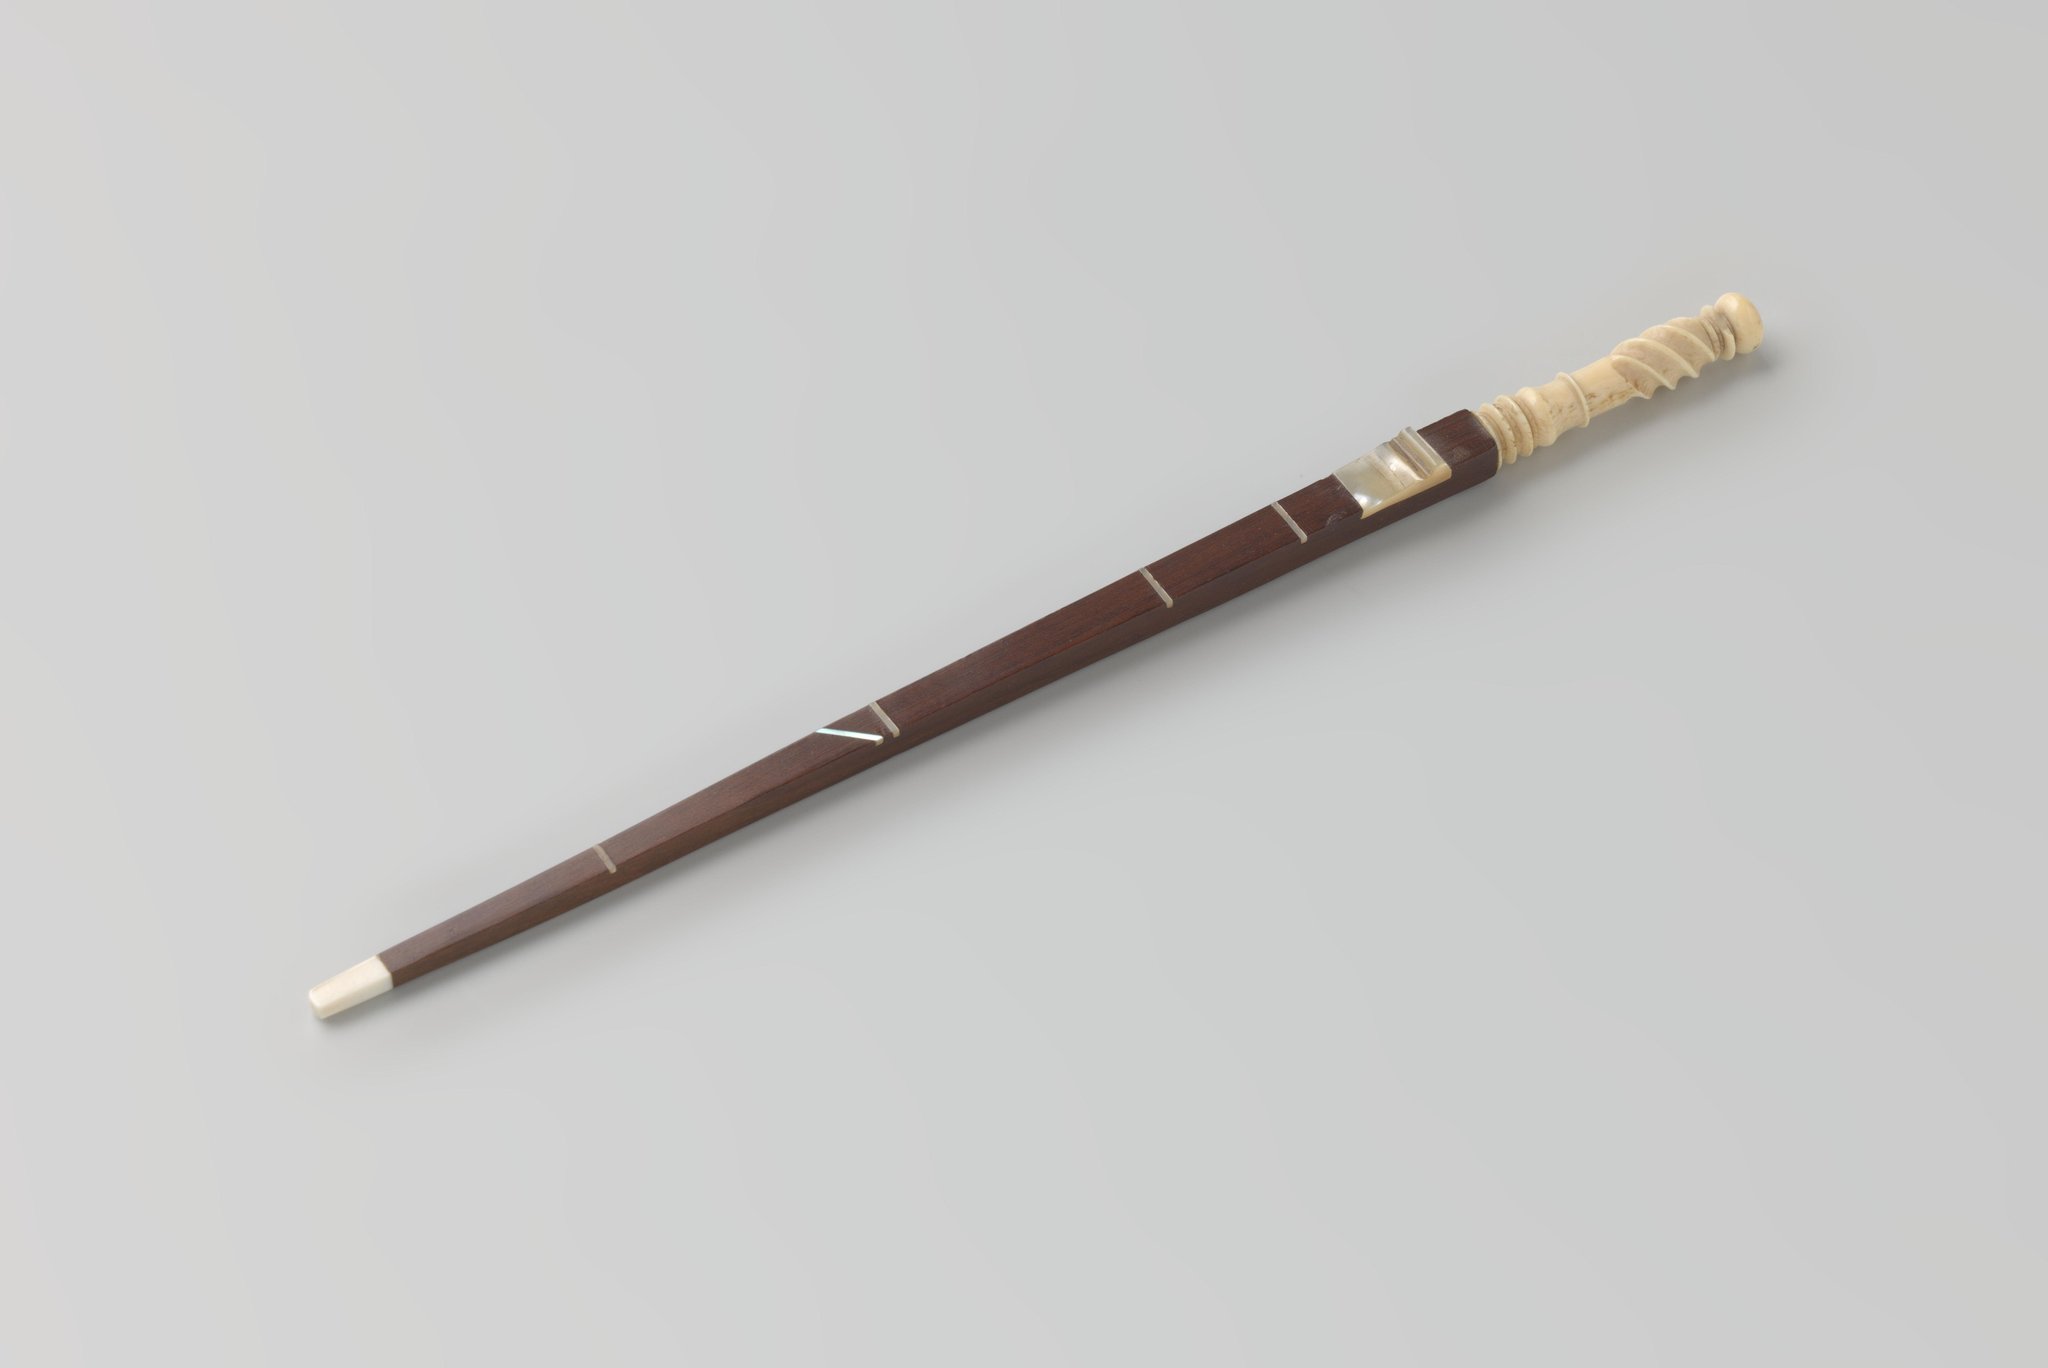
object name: ellemaat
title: Verrelmaat van hout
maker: Anonymous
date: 1400-1950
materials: ivory, mother of pearl, wood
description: Verrelmaat van hout. Een verrelmaat is een ¼ el.